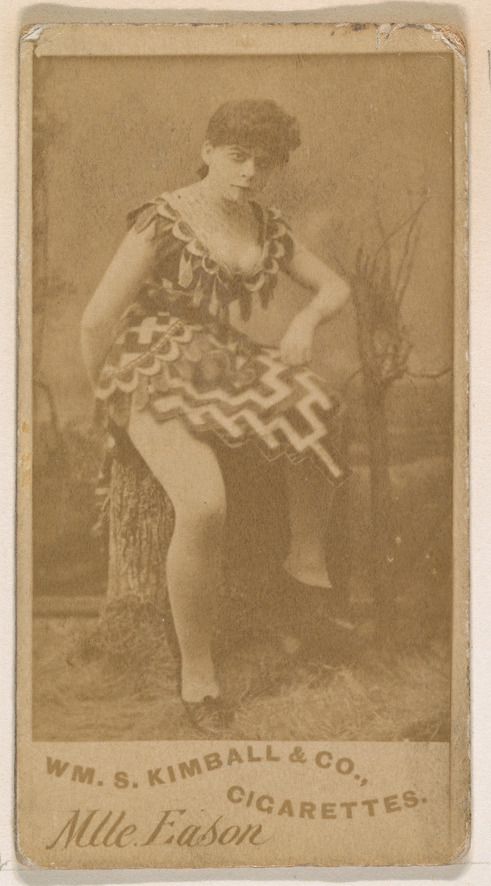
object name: photograph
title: Mlle. Eason, from the Actresses series (N203) issued by Wm. S. Kimball & Co.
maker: william s. kimball & company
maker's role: publisher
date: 1889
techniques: color lithograph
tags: portraits,women,actresses